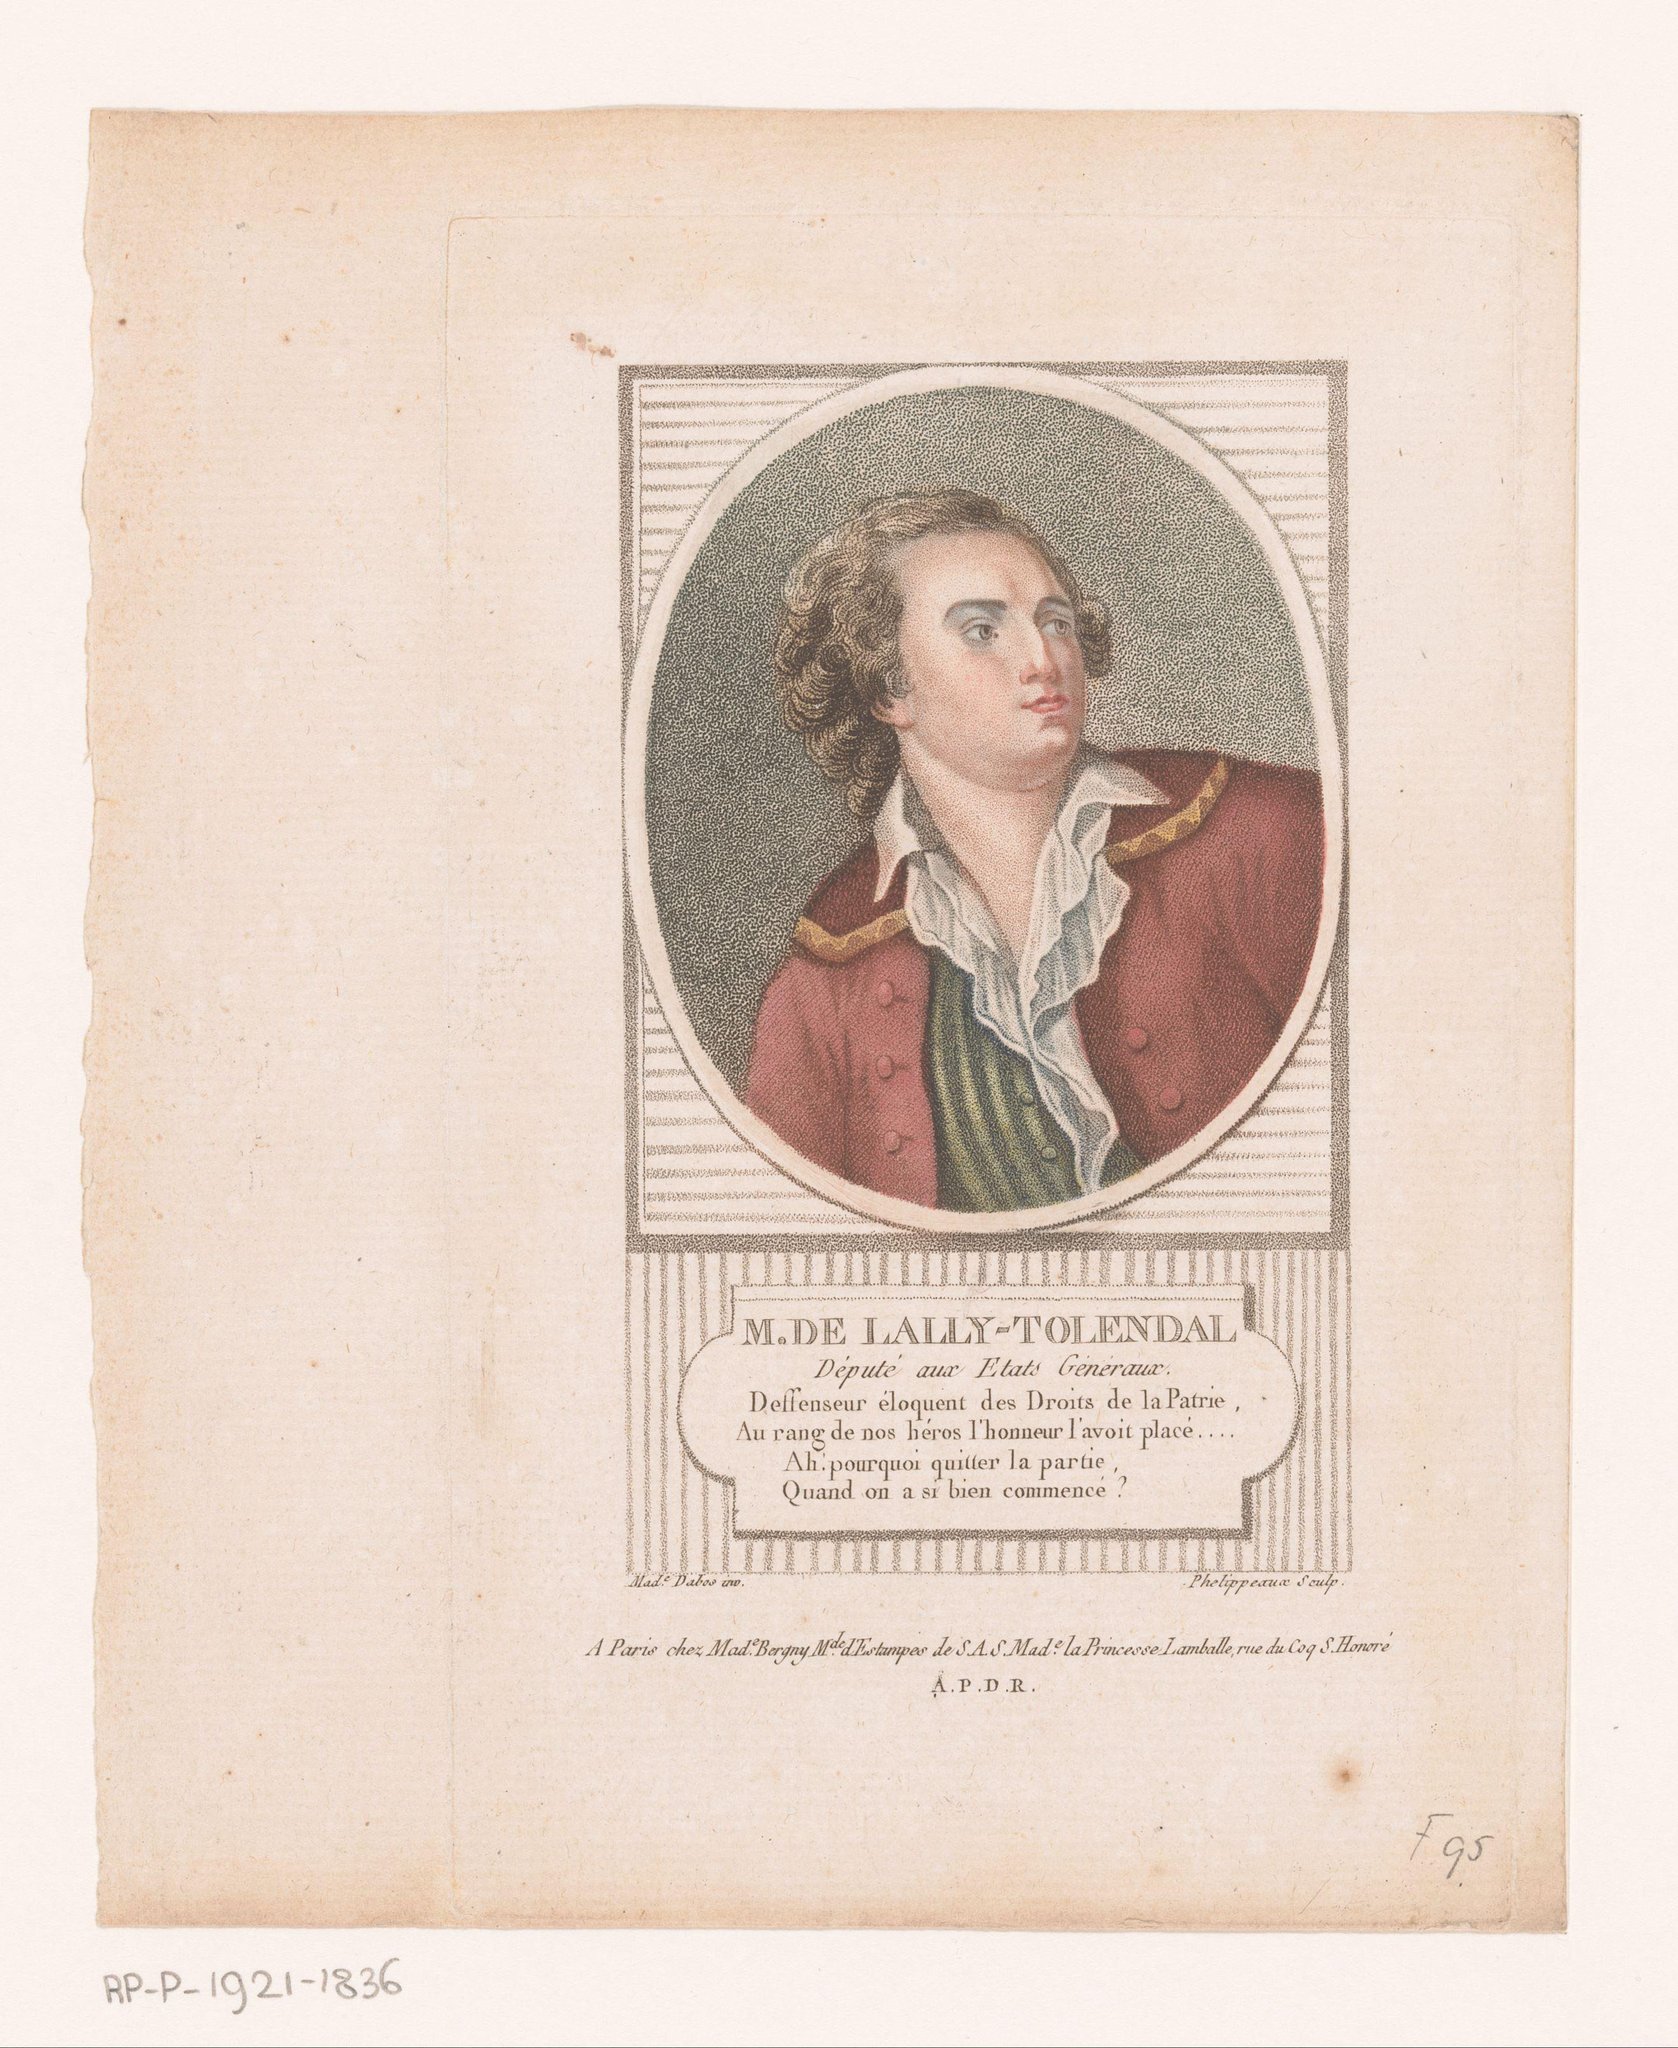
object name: print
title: M. De Lally-Tolendal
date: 1788-1802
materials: paper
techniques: etching, lithography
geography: paris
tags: paris, politician, gérard de lally-tollendal, historical persons, politician, e.g. party leader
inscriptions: collector's mark: Lugt 2233